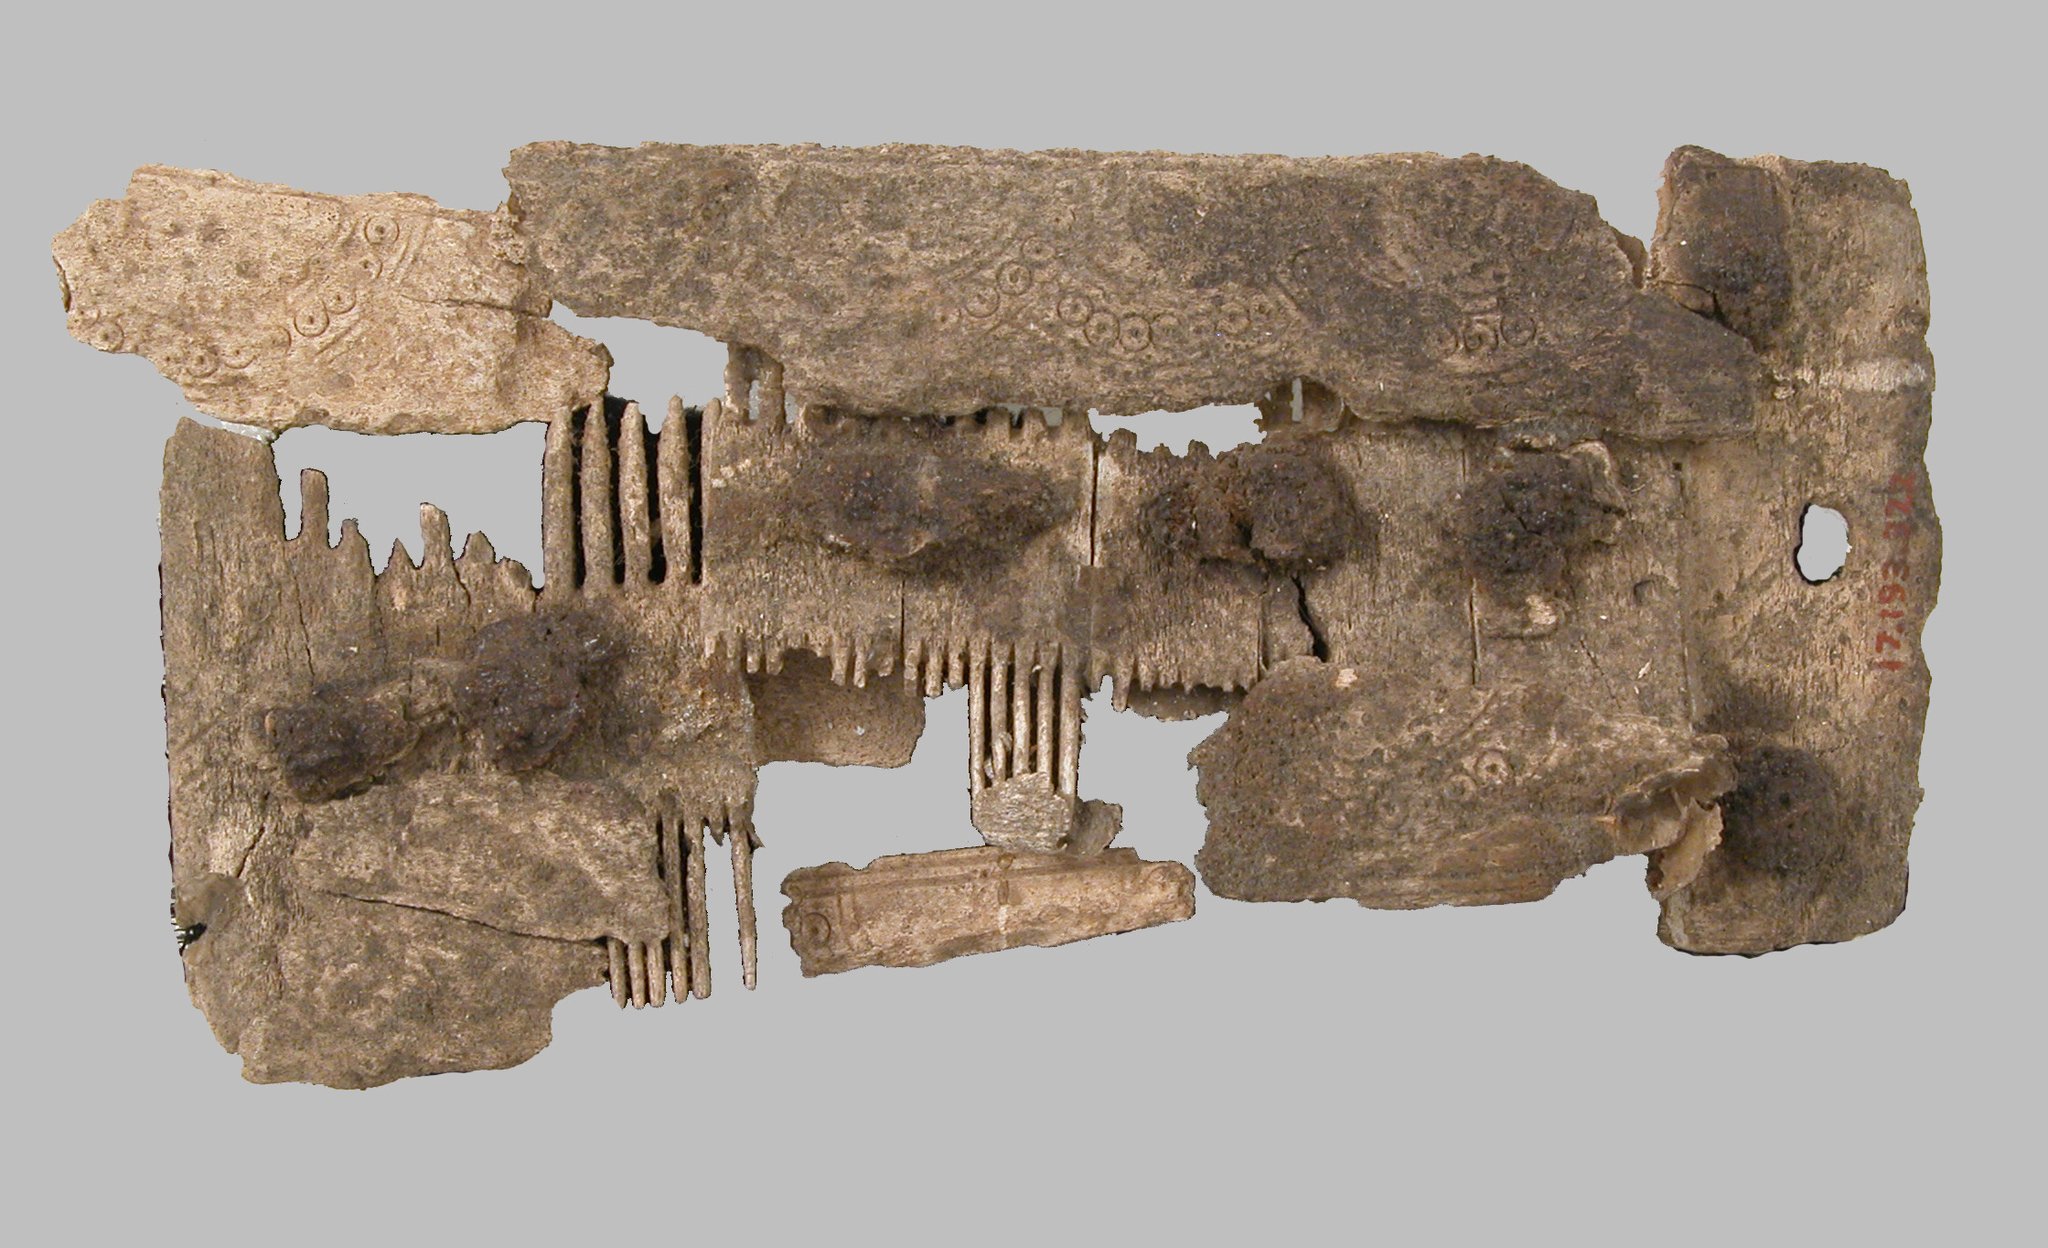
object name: comb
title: Double-Sided Comb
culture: frankish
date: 601-700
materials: bone, iron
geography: germany